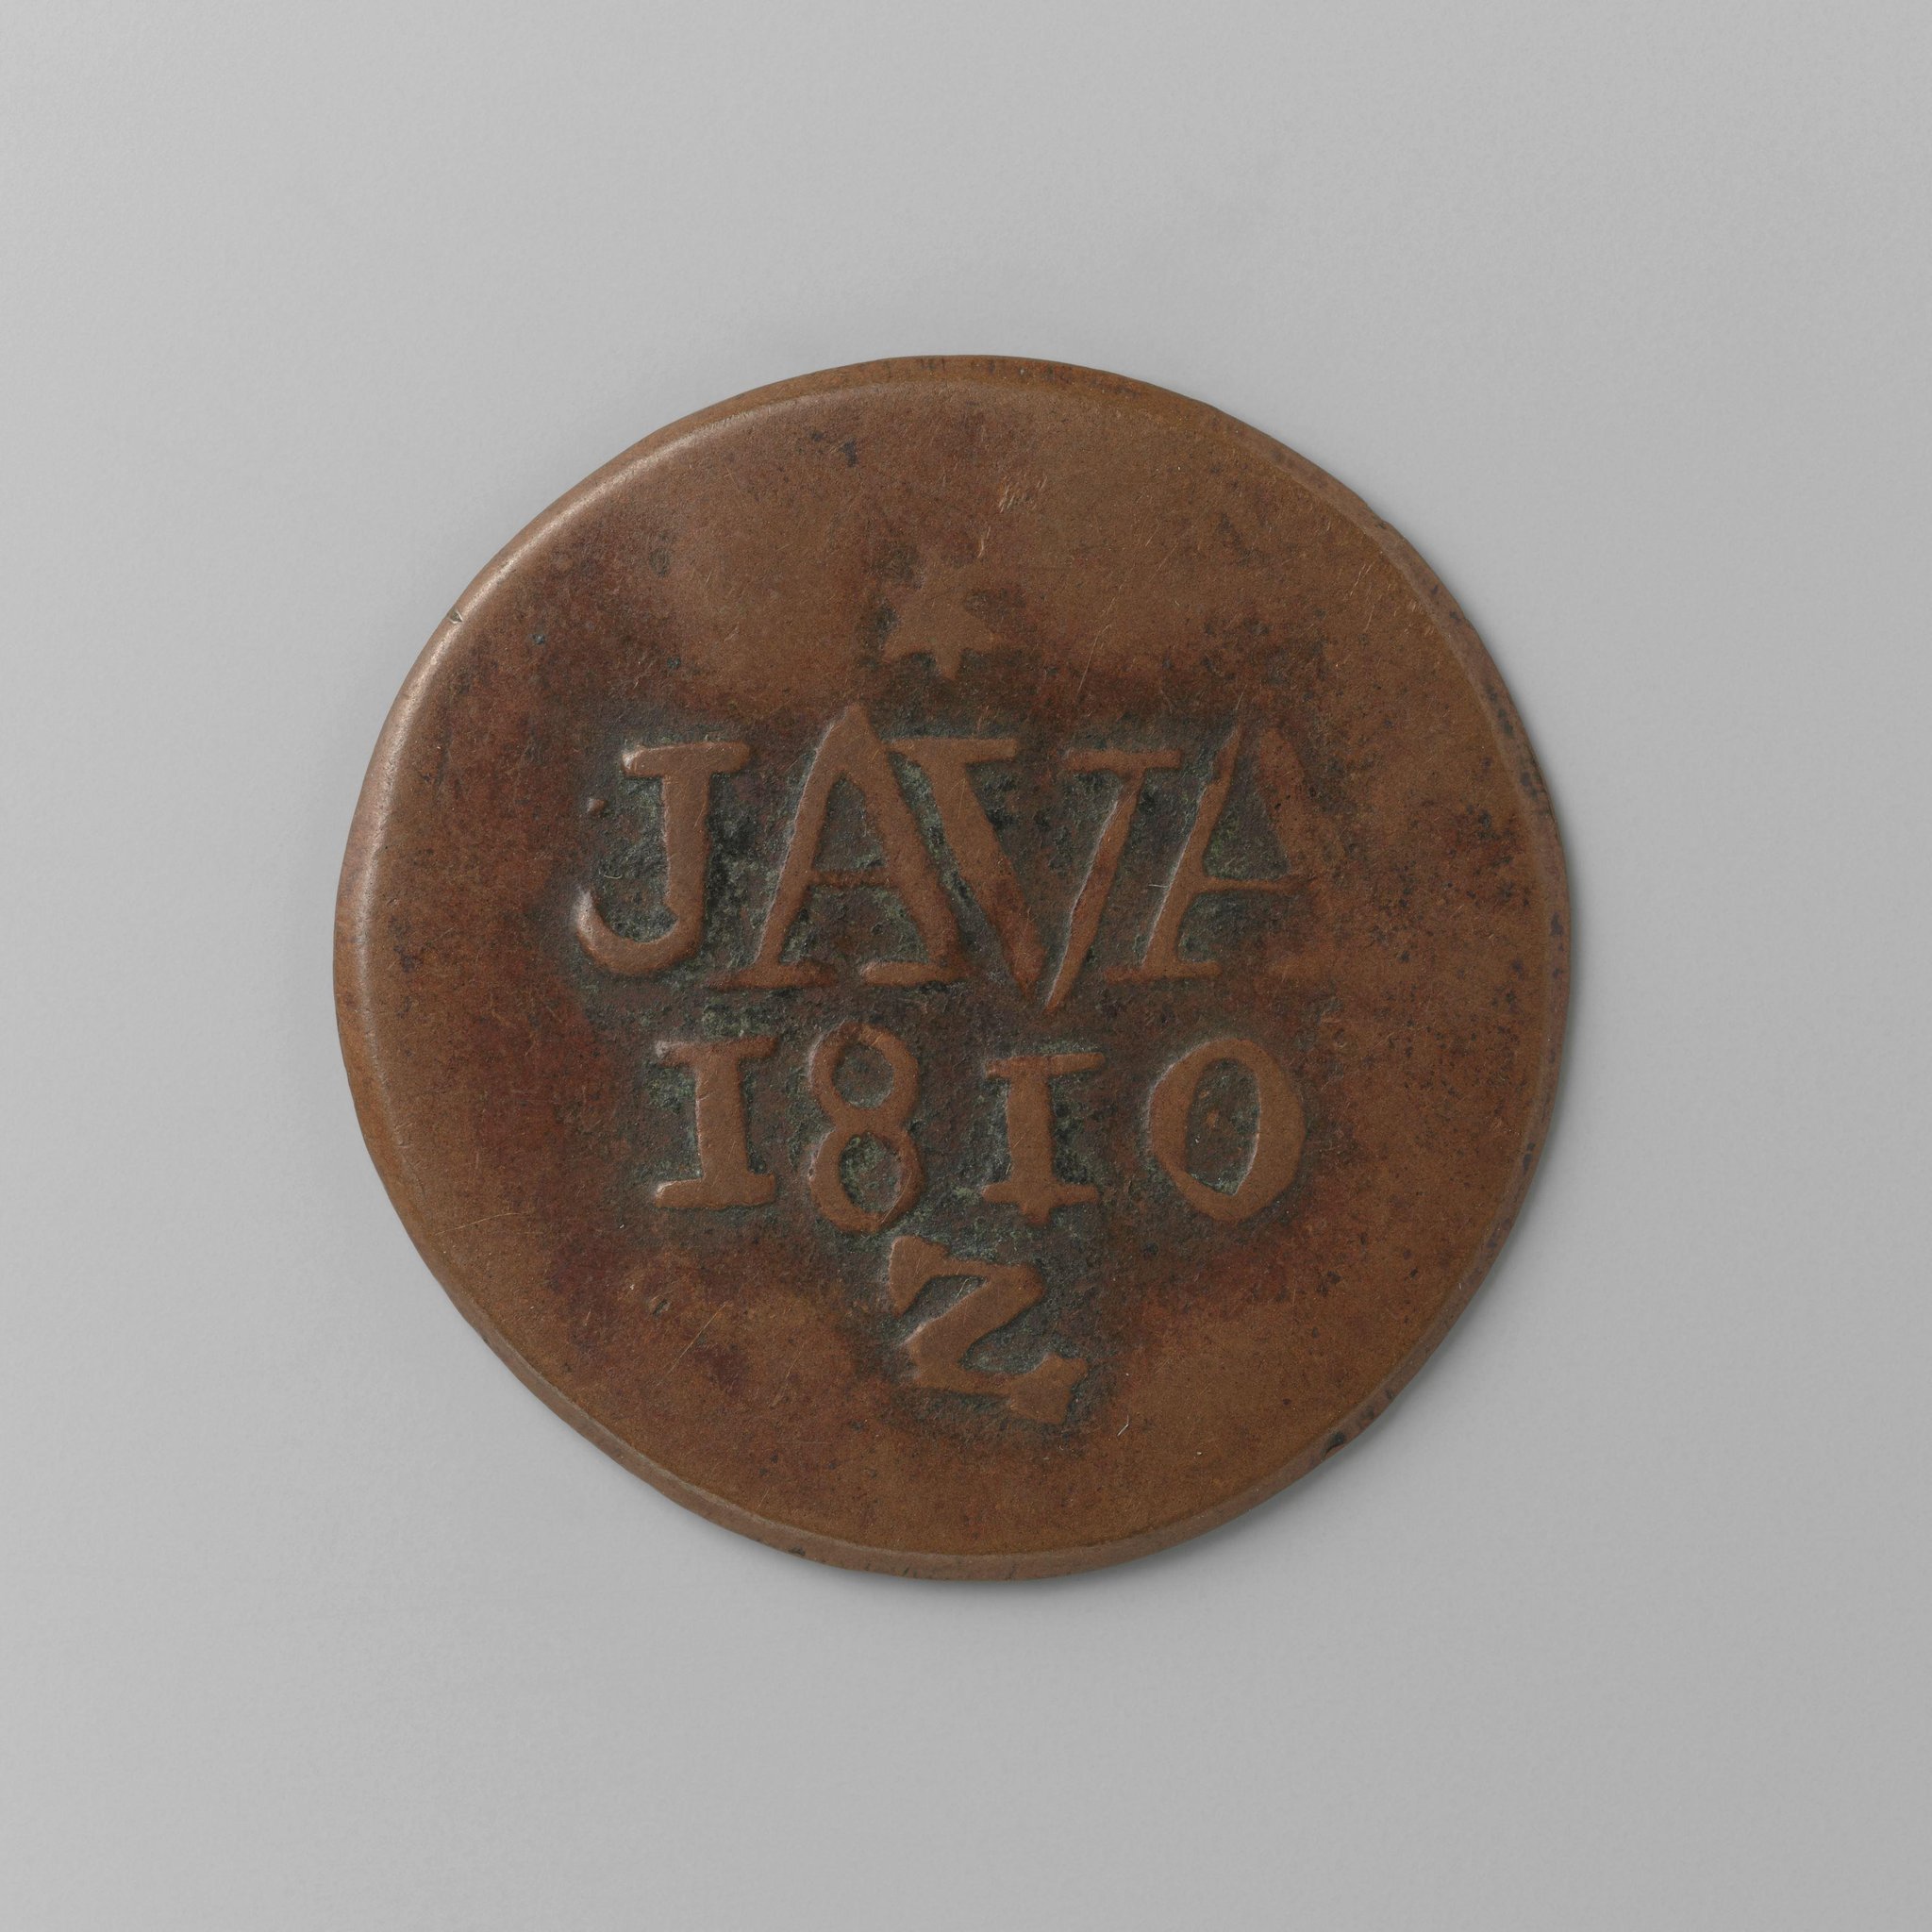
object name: coin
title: Duit voor Nederlands Indië uit Java,1810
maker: louis napoleon (king of holland)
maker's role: koning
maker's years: 1778-1846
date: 1810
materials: copper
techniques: striking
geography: surabaya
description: Koperen munt. Voorzijde: initialen L en N van Lodewijk Napoleon. Daarboven muntteken. Keerzijde: eenregelig opschrift, waaronder jaartal. Boven opschrift muntteken en onder jaartal muntmeesterteken Z [=muntmeester Zwekkert].